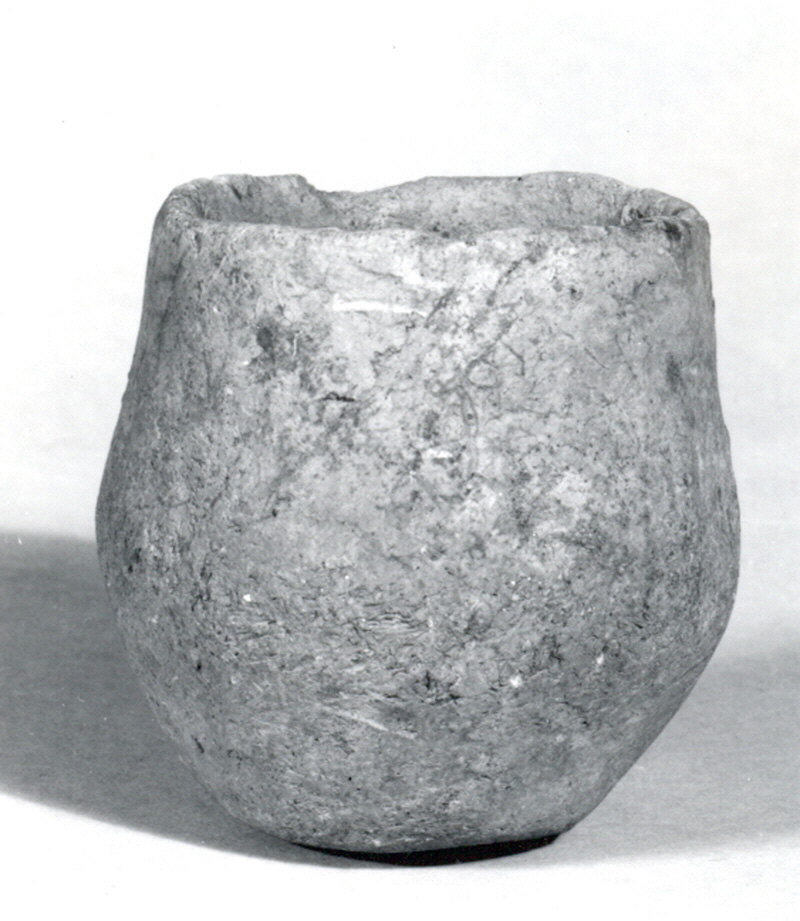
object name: pot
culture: iranian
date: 6000-5001 BCE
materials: ceramic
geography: iran